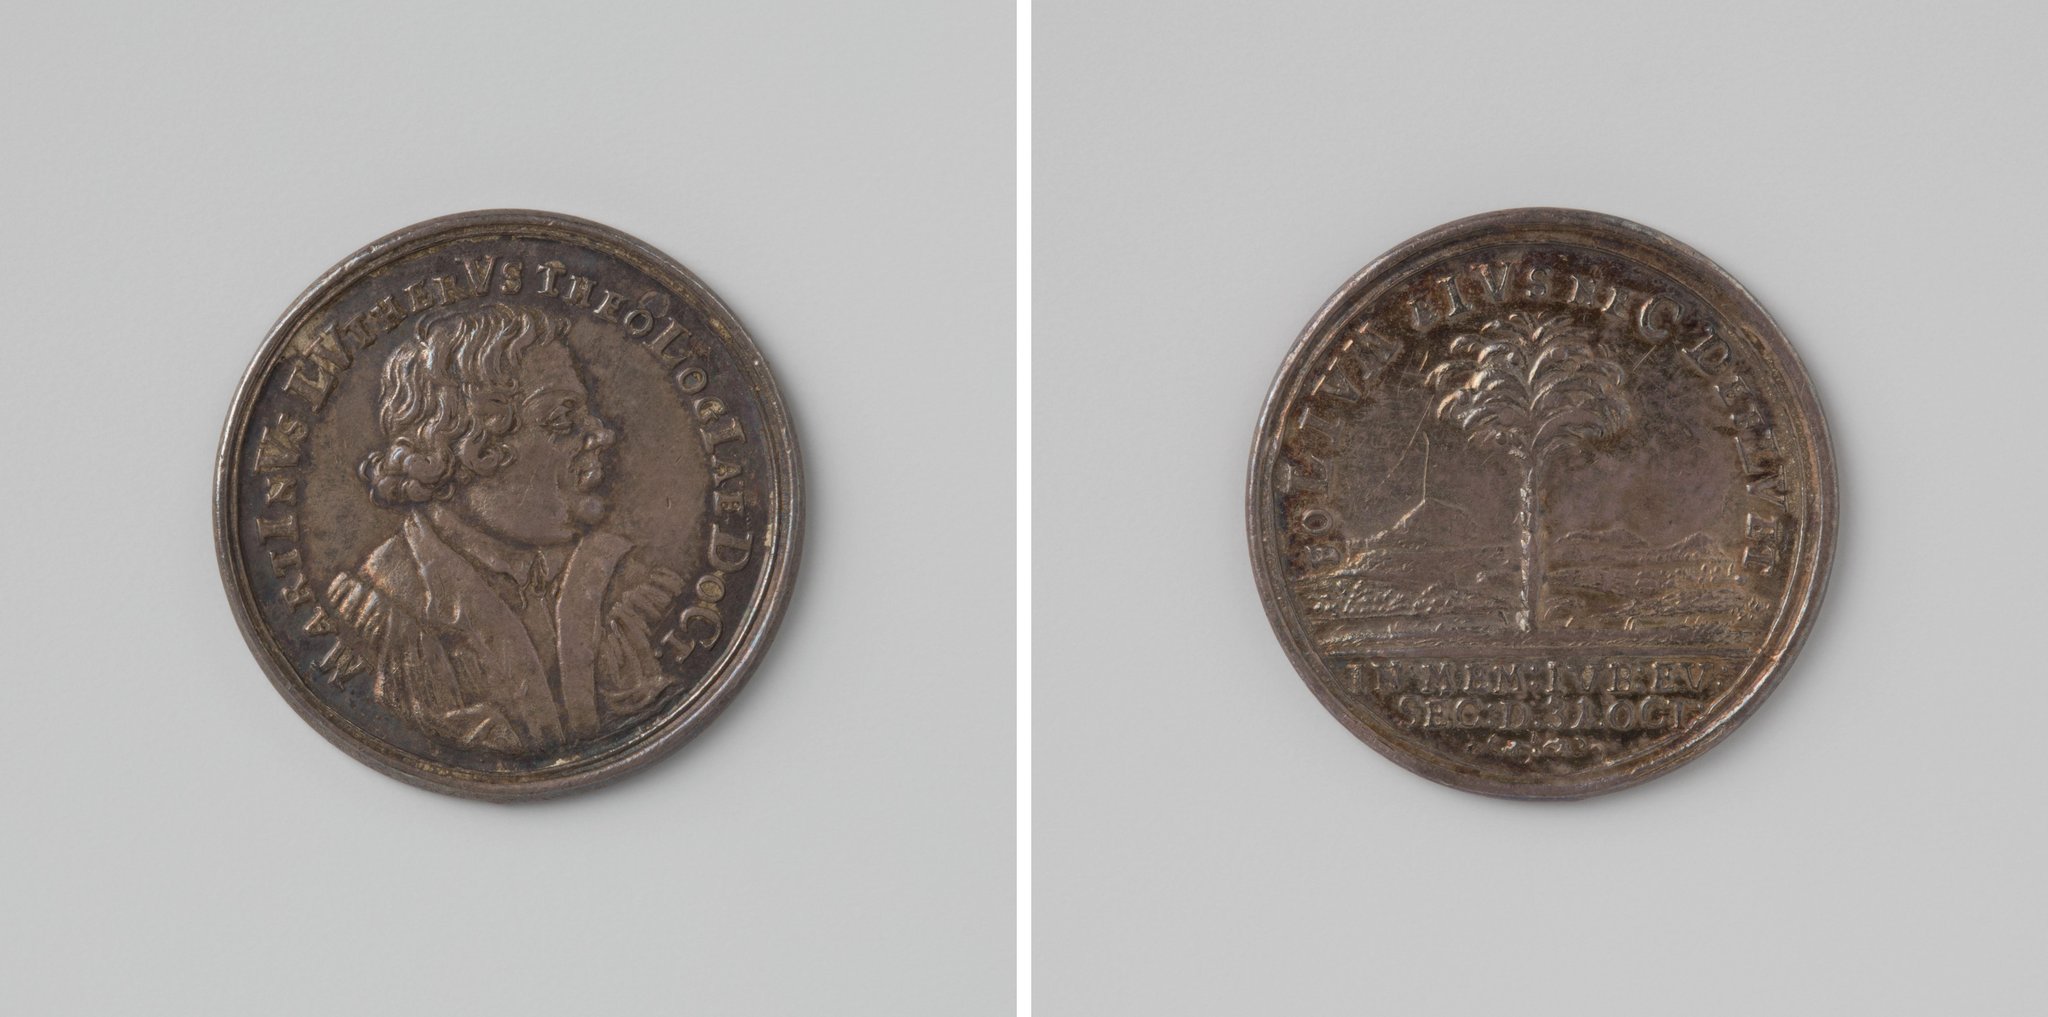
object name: history medal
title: Tweede eeuwfeest van de Reformatie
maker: philipp heinrich müller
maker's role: medailleur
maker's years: 1654-1719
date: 1717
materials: silver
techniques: striking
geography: nuremberg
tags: priest, martin luther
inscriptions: caption: ‘IN MEMORIAM/ IVBILÆI EVANGELICI/ SECVNDI . D . 31 . OCT .’, circumscription: ‘FOLIVM EIVS NEC DEFLVET.’, circumscription: ‘MARTINUS LVTHERUS THEOLOGIAE DOCT.’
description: Zilveren penning. Voorzijde: borststuk man binnen omschrift. Keerzijde: palmboom met op achtergrond berglandschap binnen omschrift; afsnede: opschrift.